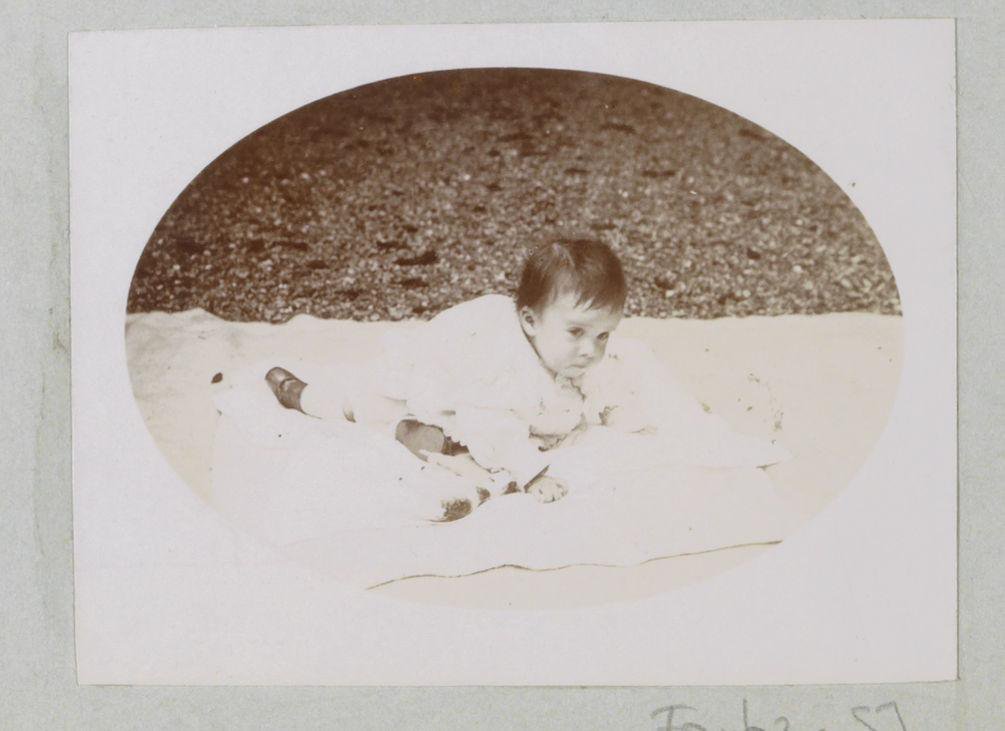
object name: photograph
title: Portret van een peuter, liggend op een deken, vermoedelijk in Frankrijk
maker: delizy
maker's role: manufacturer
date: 1903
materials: paper, photographic support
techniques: gelatin silver print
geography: france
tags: tot, toddler ~ the ages of man, france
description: Onderdeel van Fotoalbum van een Franse amateurfotograaf met opnames van uitstapjes in Frankrijk, Spanje, België, Luxemburg en Nederland, de eerste automobielen en autoraces.